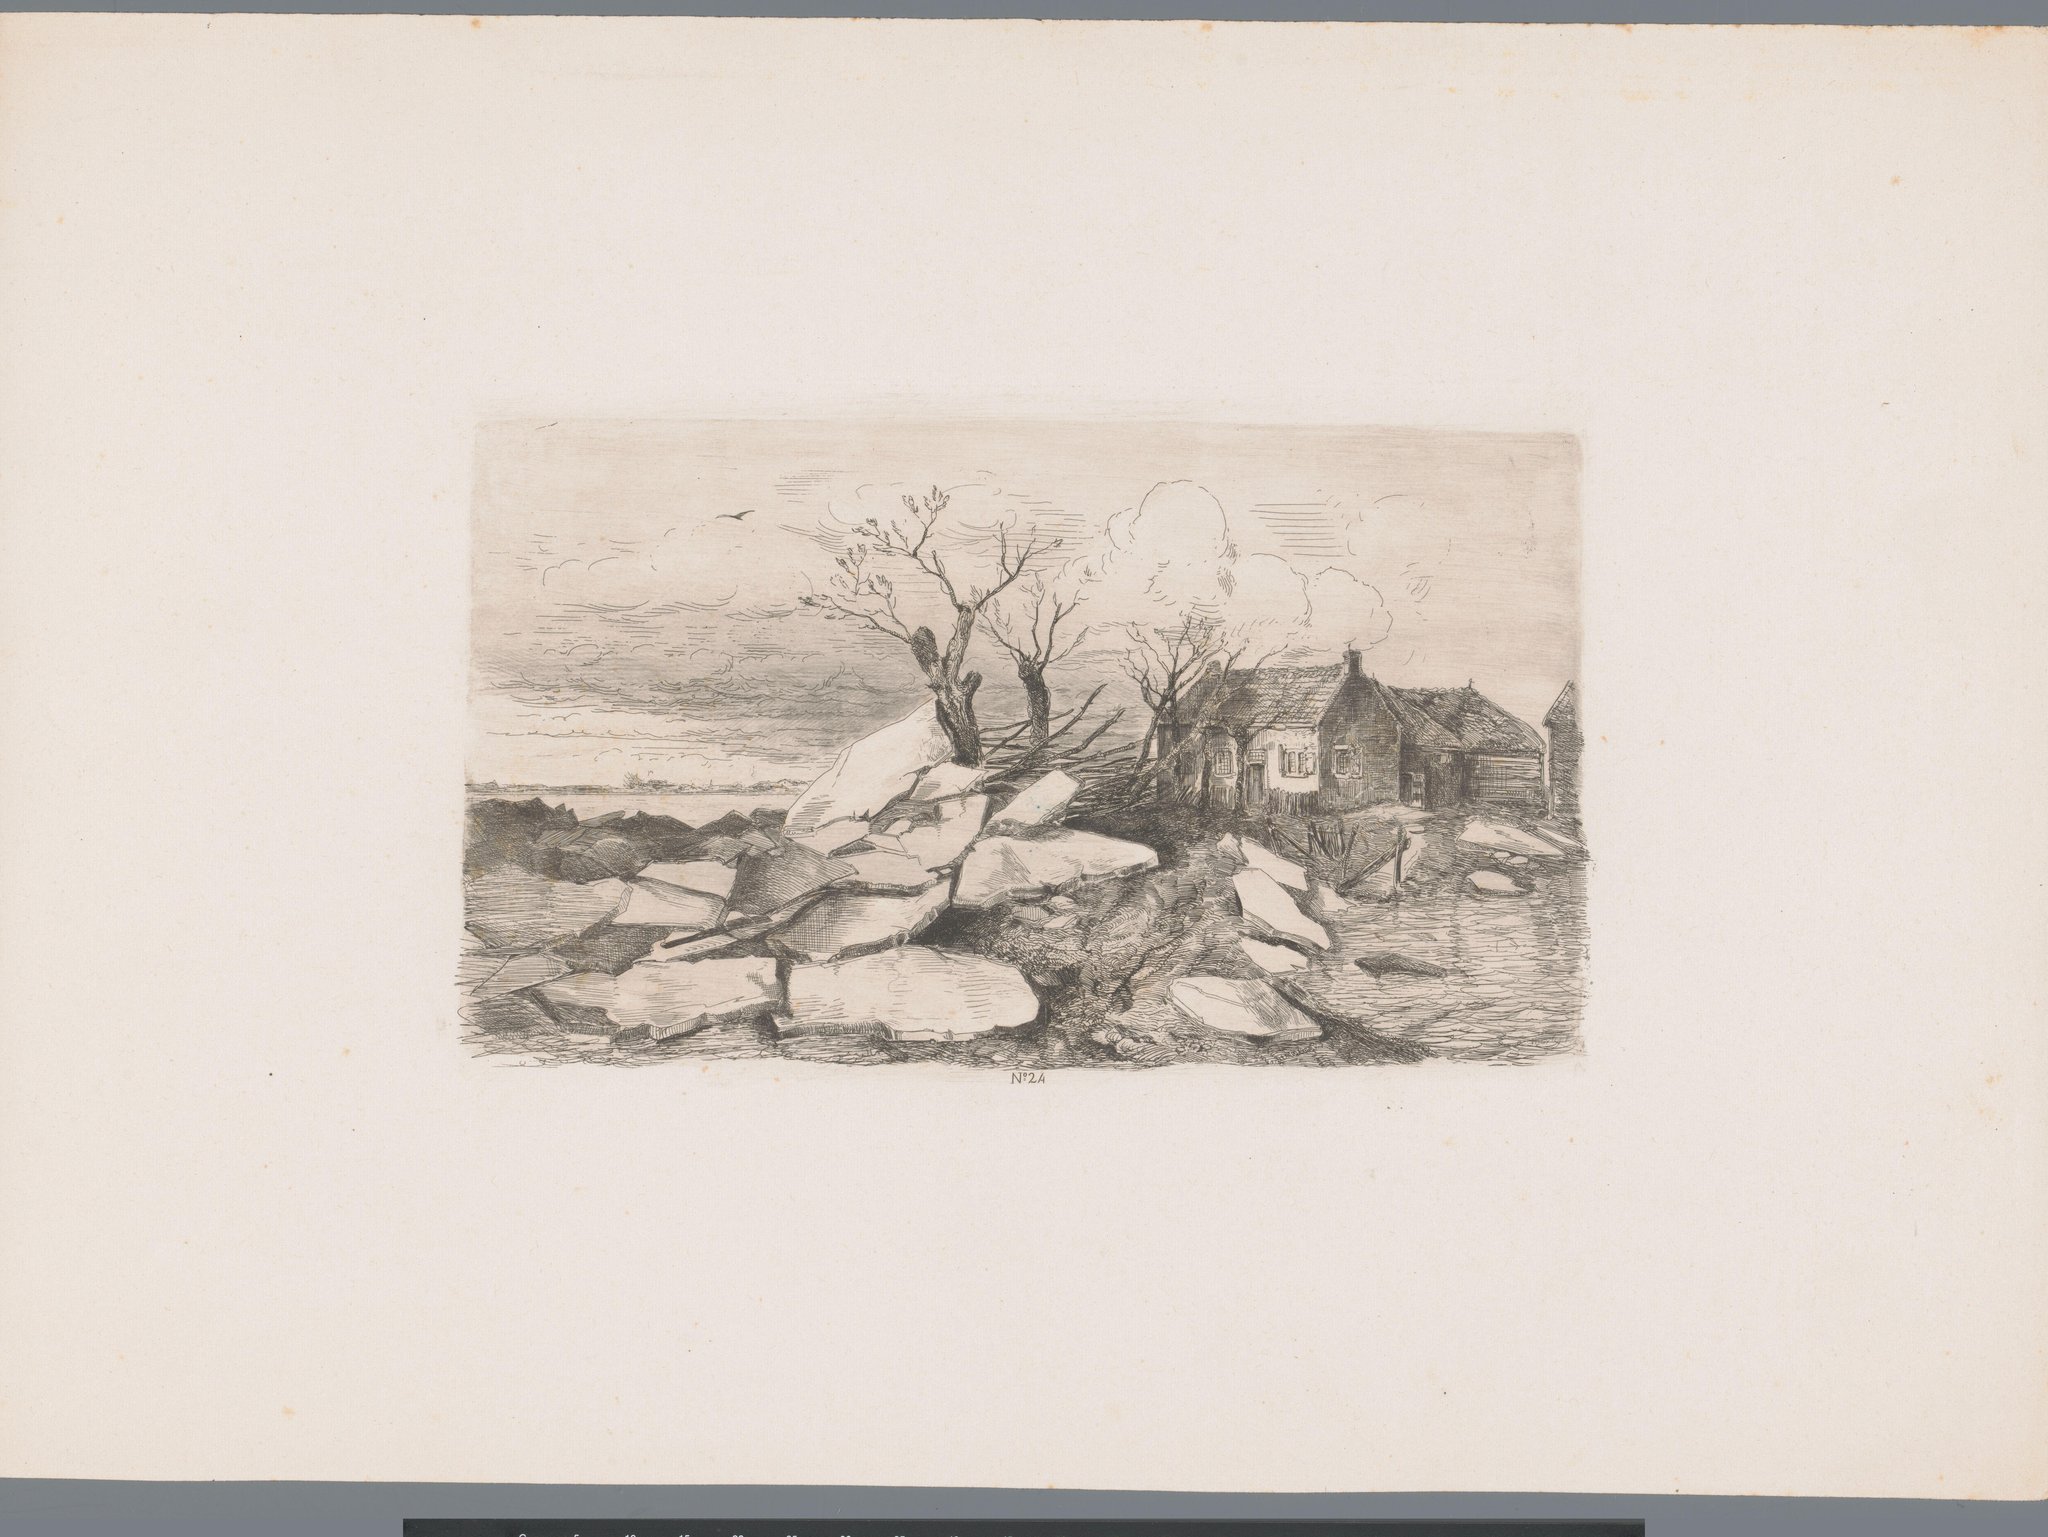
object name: print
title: Kruiend ijs te Altenaar, 1855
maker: mari ten kate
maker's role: draughtsman, painter, print maker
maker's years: 1831-1910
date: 1855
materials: paper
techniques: etching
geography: netherlands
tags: flood, drift ice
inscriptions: collector's mark: Lugt 2228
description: Een boerderij te Altenaar bij Elst wonderlijk gespaard door het kruiend ijs, 9 maart 1855. Onderdeel van de reeks van 24 prenten over de watersnood van maart 1855, door leden van het genootschap Arti et Amicitiae. Uitgave ten behoeve van de slachtoffers van de watersnood.